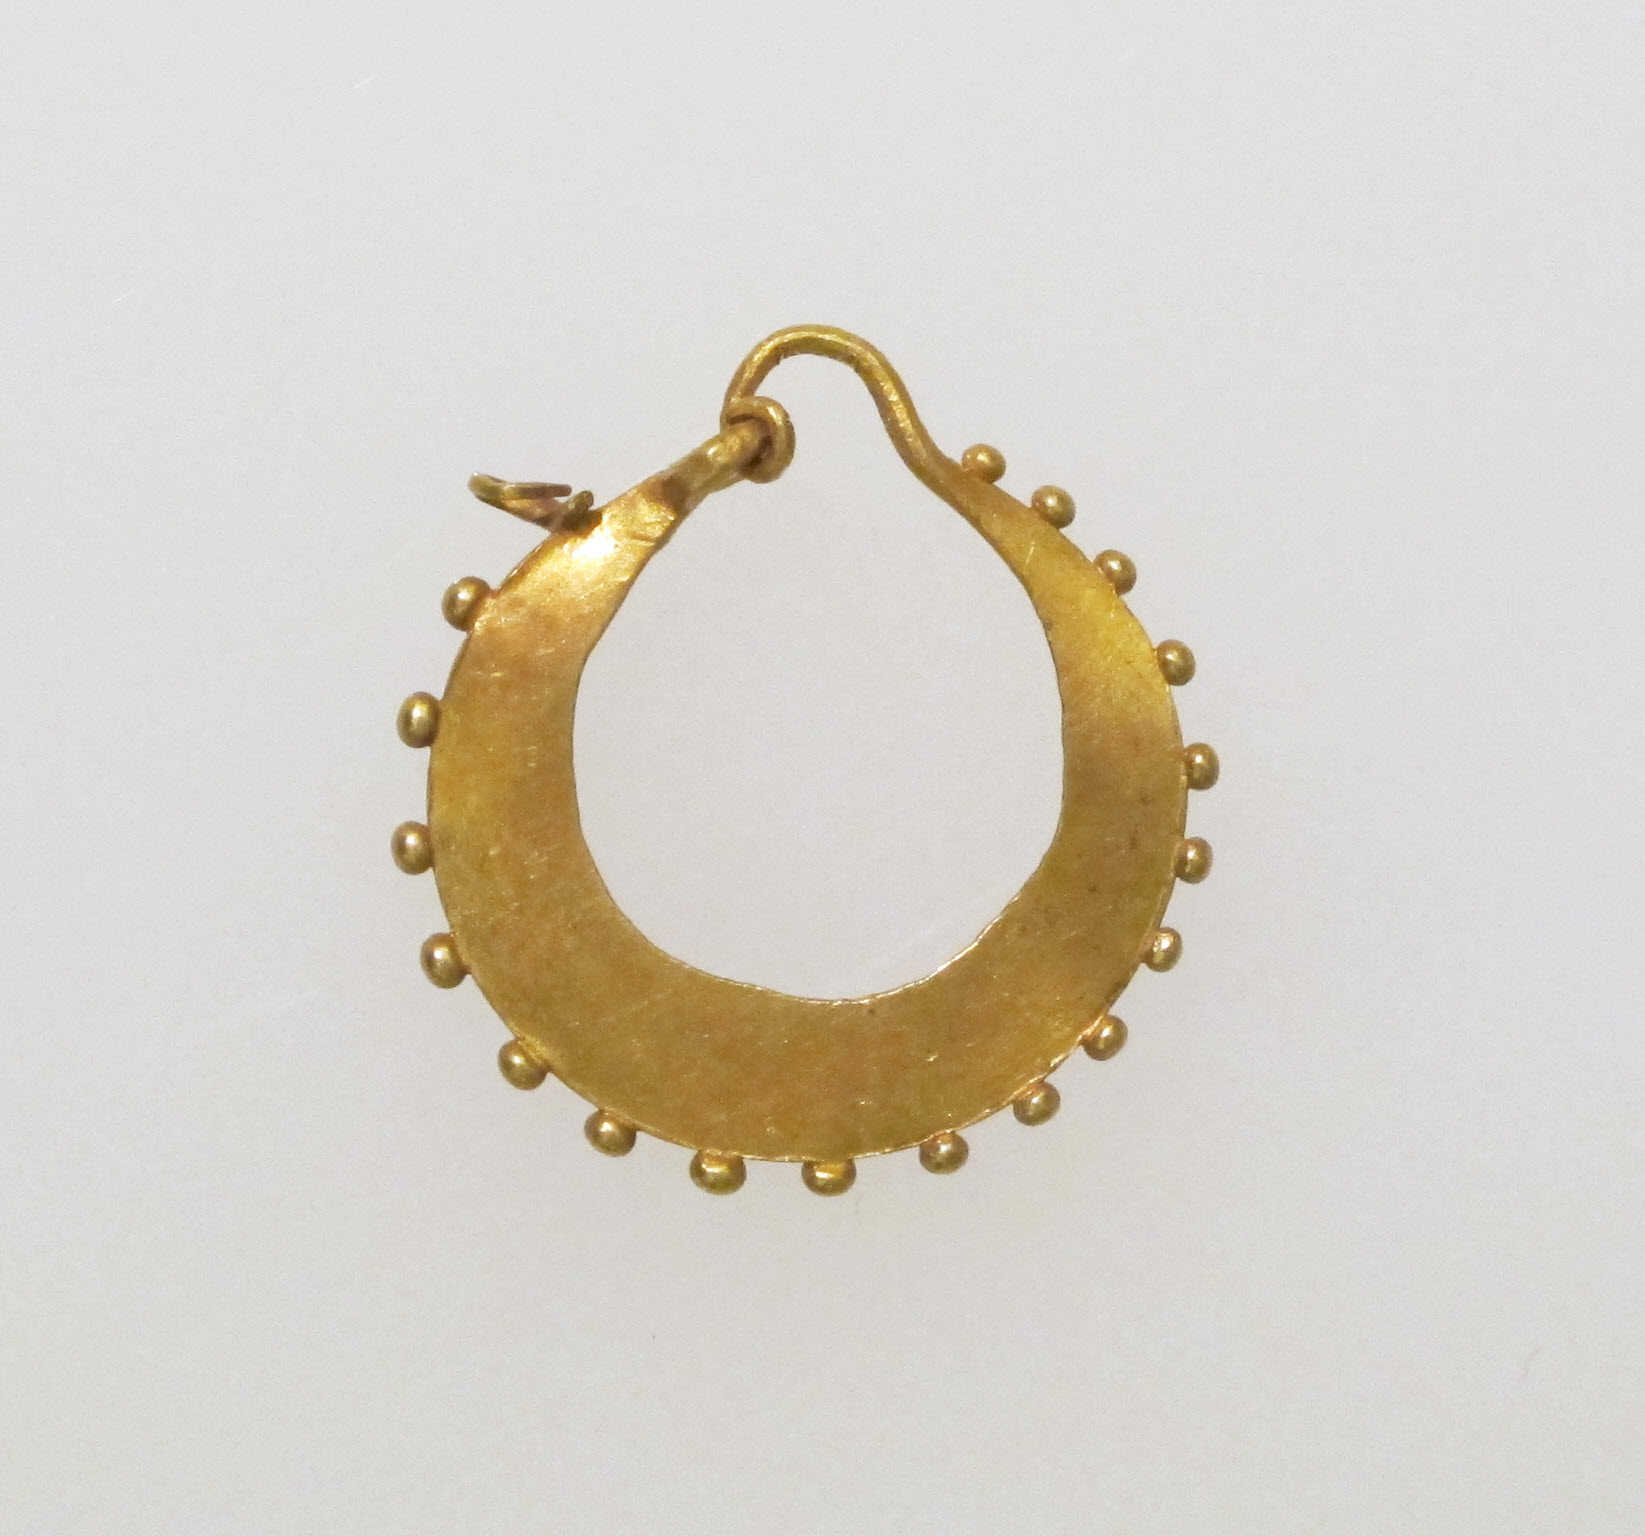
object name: earring, crescent shaped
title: Earring, crescent-shaped, decorated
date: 7000 BCE-330 CE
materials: gold